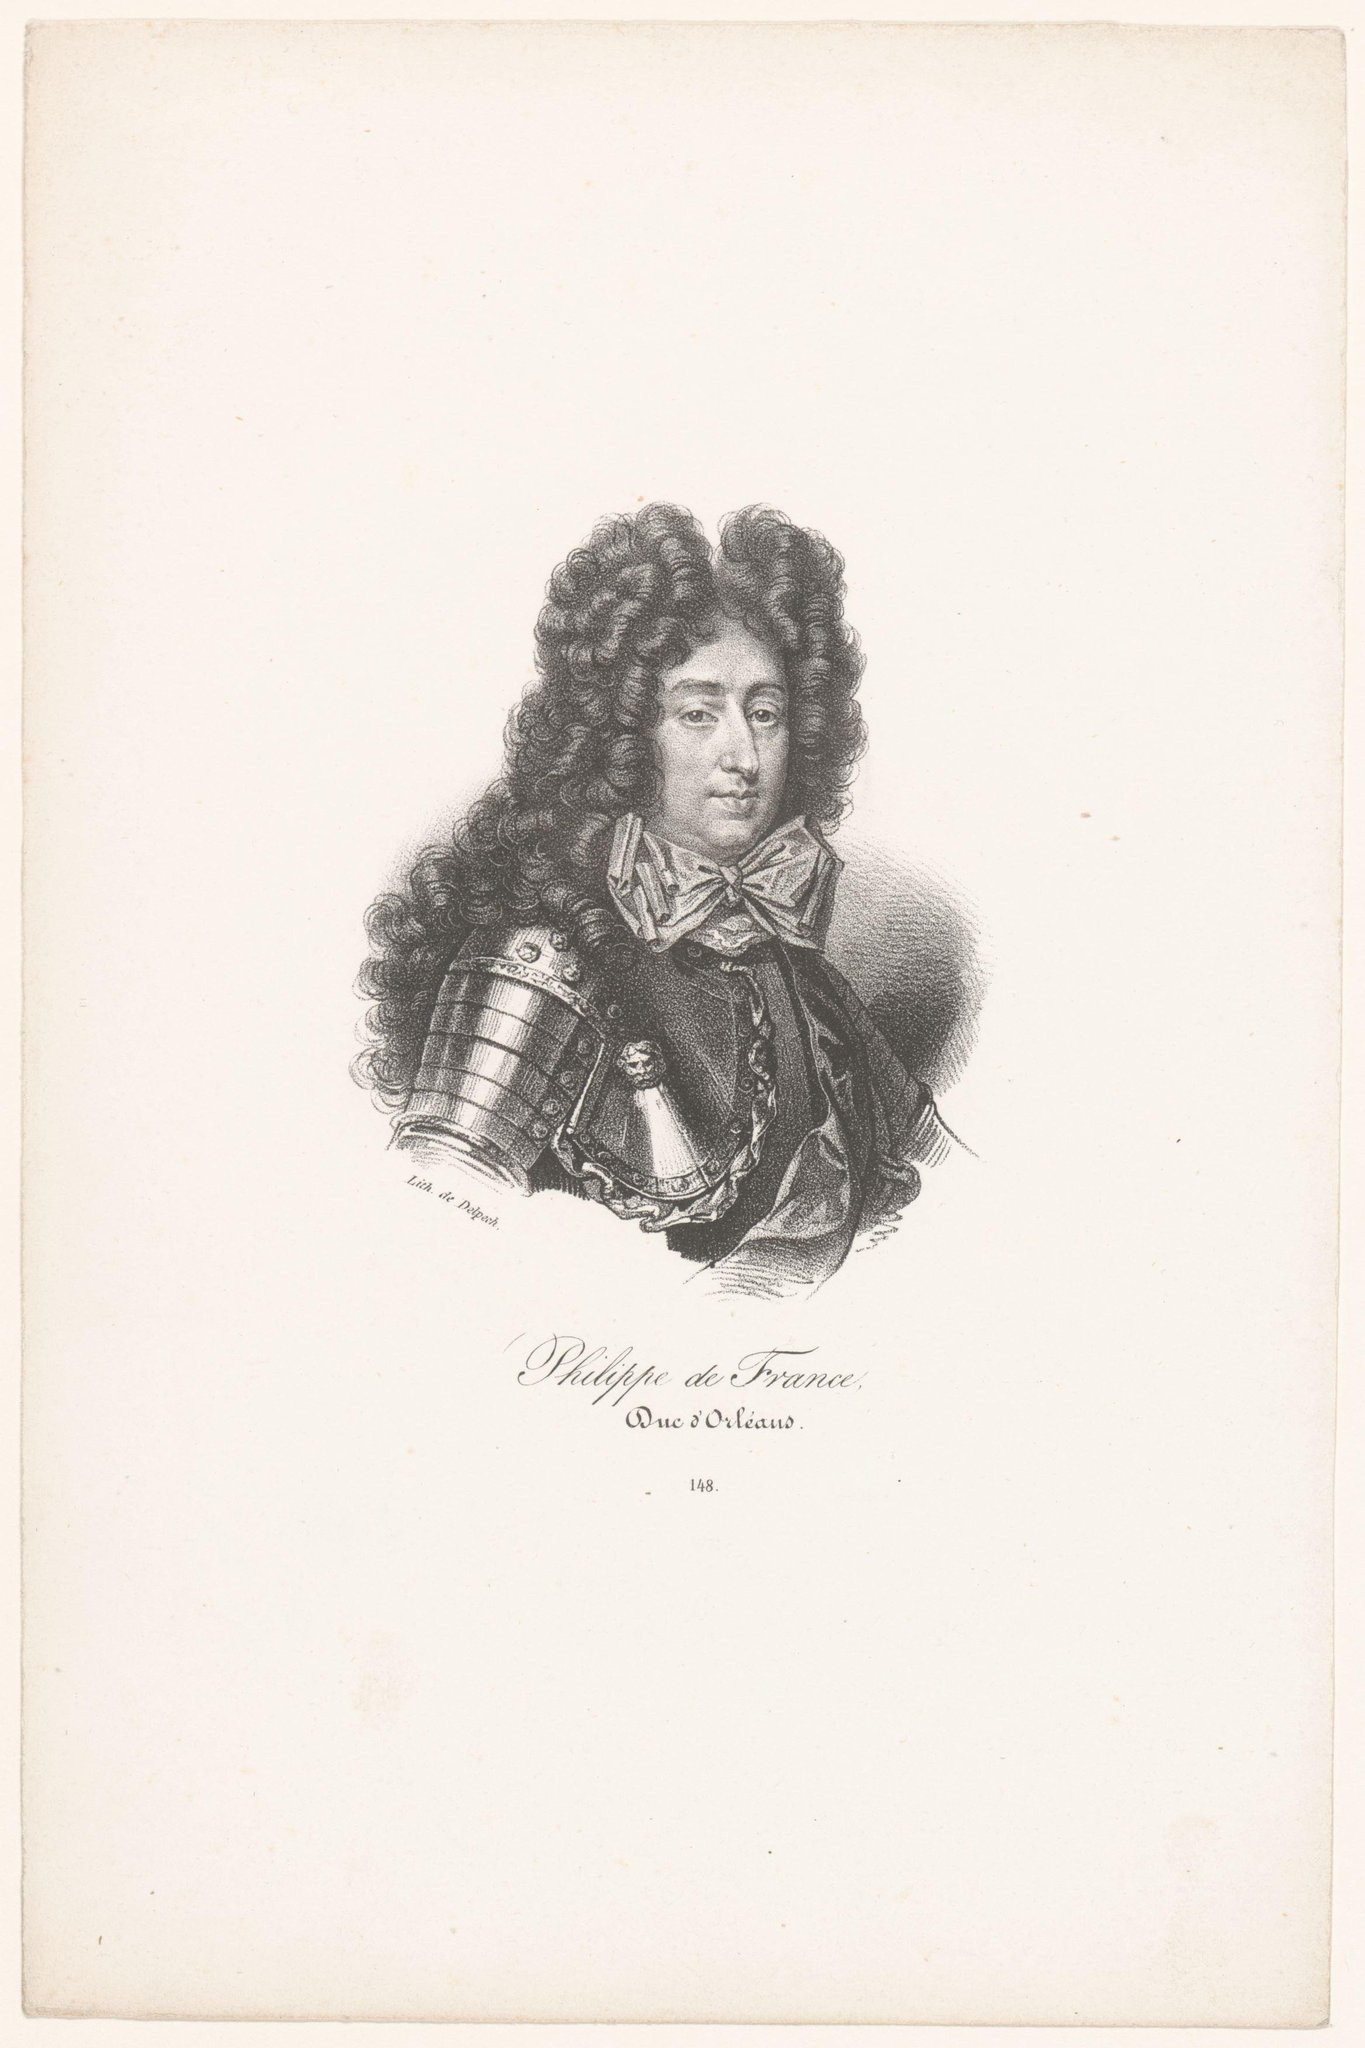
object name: print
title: Portret van Filips van Frankrijk, hertog van Orléans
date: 1818-1842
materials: paper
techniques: lithograph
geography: paris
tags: filips i (hertog van orléans), historical persons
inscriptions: collector's mark: Lugt 2228a